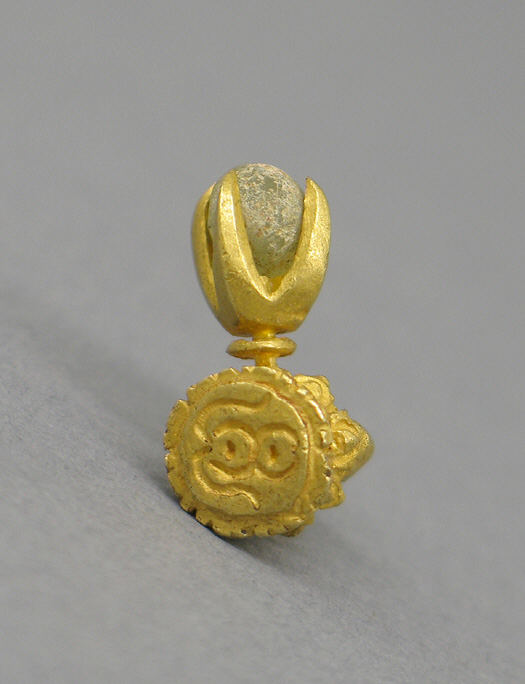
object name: ear clip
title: Ear Clip with Stone in Four Prong Lotus Base Setting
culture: indonesian, javanese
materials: gold, stone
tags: lotuses